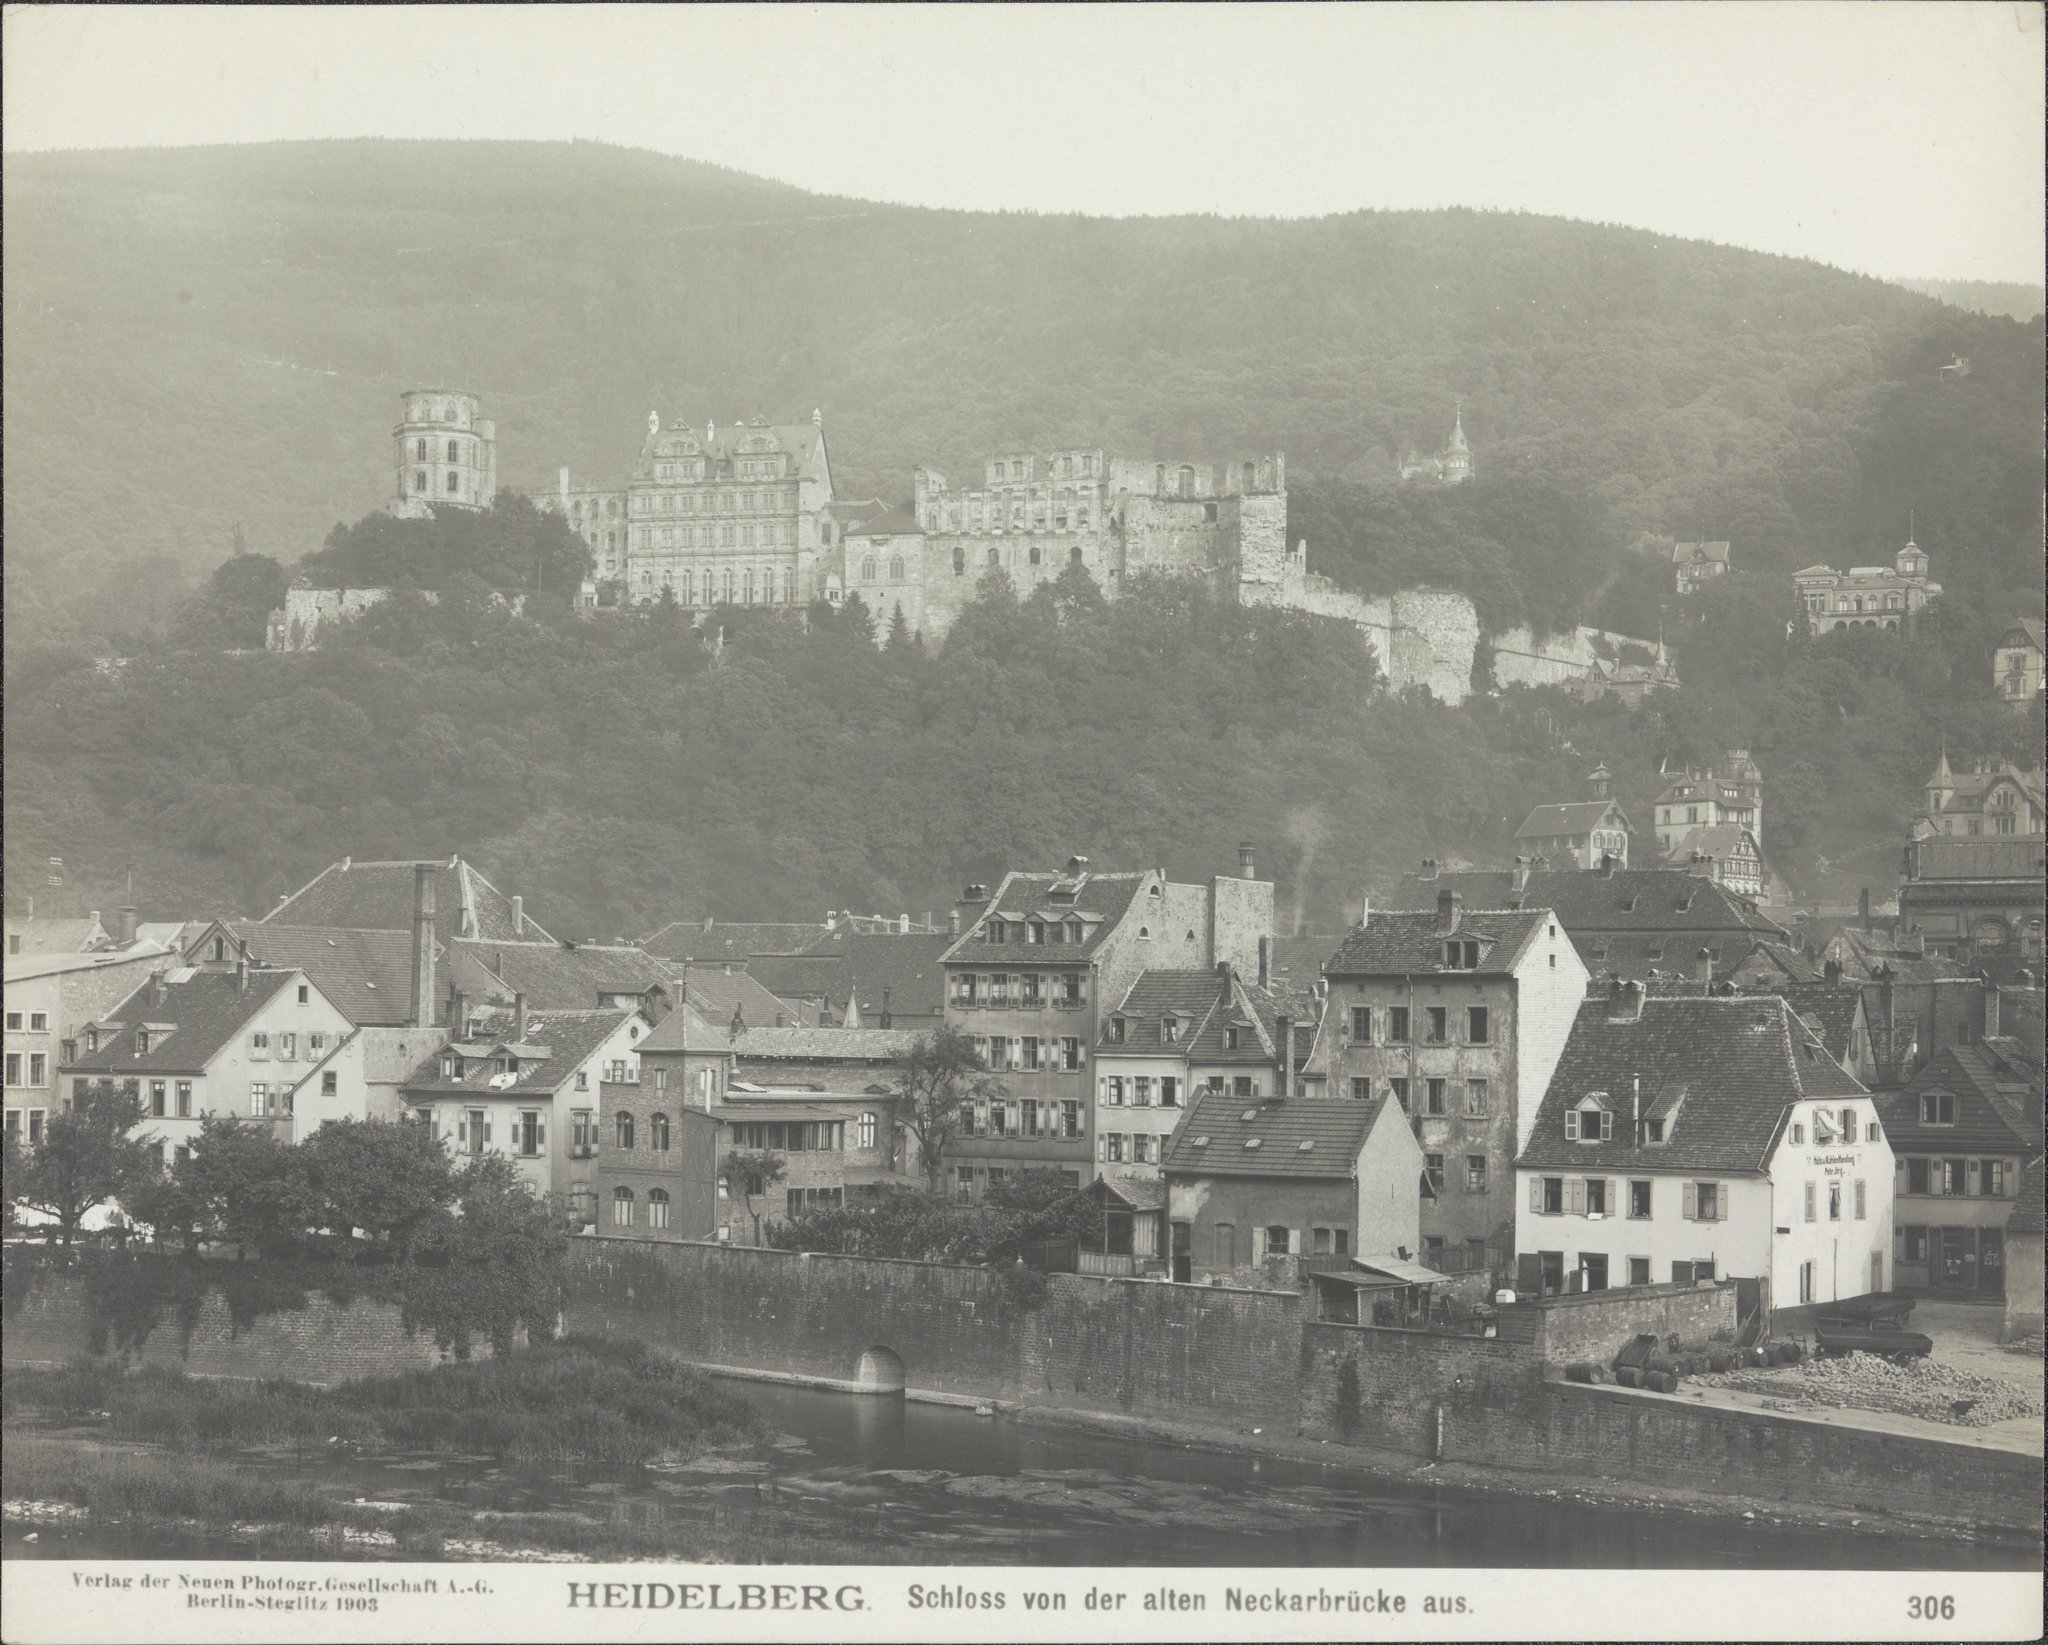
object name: photograph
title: Heidelberg gezien vanaf een brug over de Neckar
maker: Anonymous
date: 1903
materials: photographic support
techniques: gelatin silver print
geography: heidelberg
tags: castle, prospect of city, town panorama, silhouette of city, ruin of a dwelling, house, castle, etc.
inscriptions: number: ‘306’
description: Onderdeel van Fotoalbum met opnames van Heidelberg en Schloss Heidelberg.